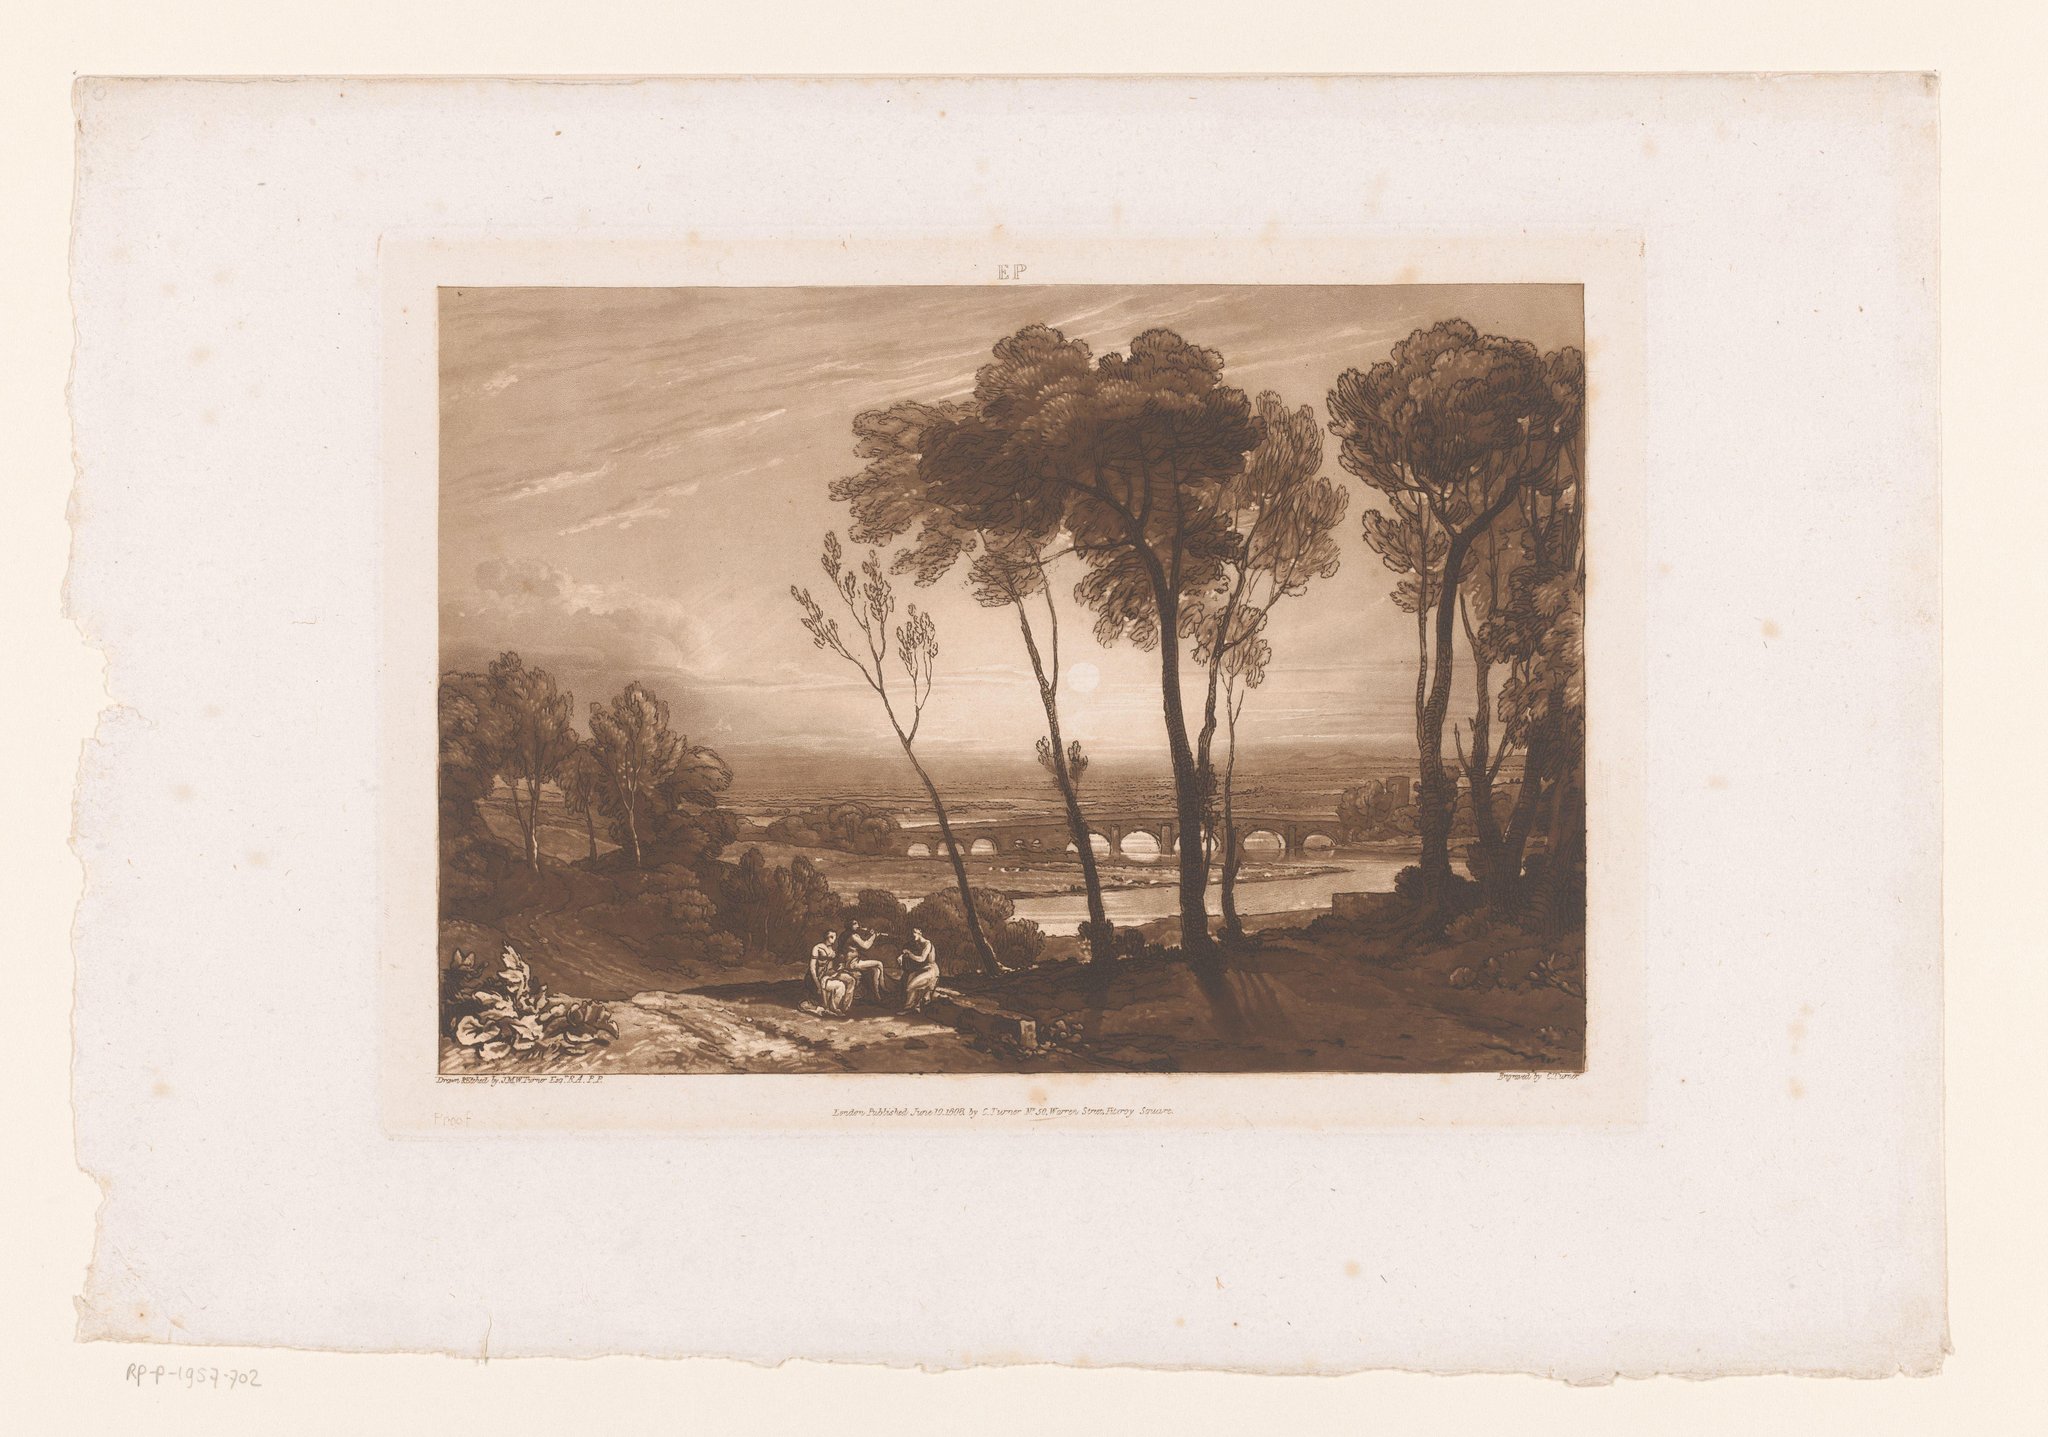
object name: print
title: Landschap met drie herders en brug met acht bogen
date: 1806-1808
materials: paper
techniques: aquatint, etching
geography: london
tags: herding, herdsman, herdswoman, shepherd, shepherdess, cowherd, etc., landscape with bridge, viaduct or aqueduct - ii - ideal landscapes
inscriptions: collector's mark: Lugt 2760, collector's mark: Lugt 2228